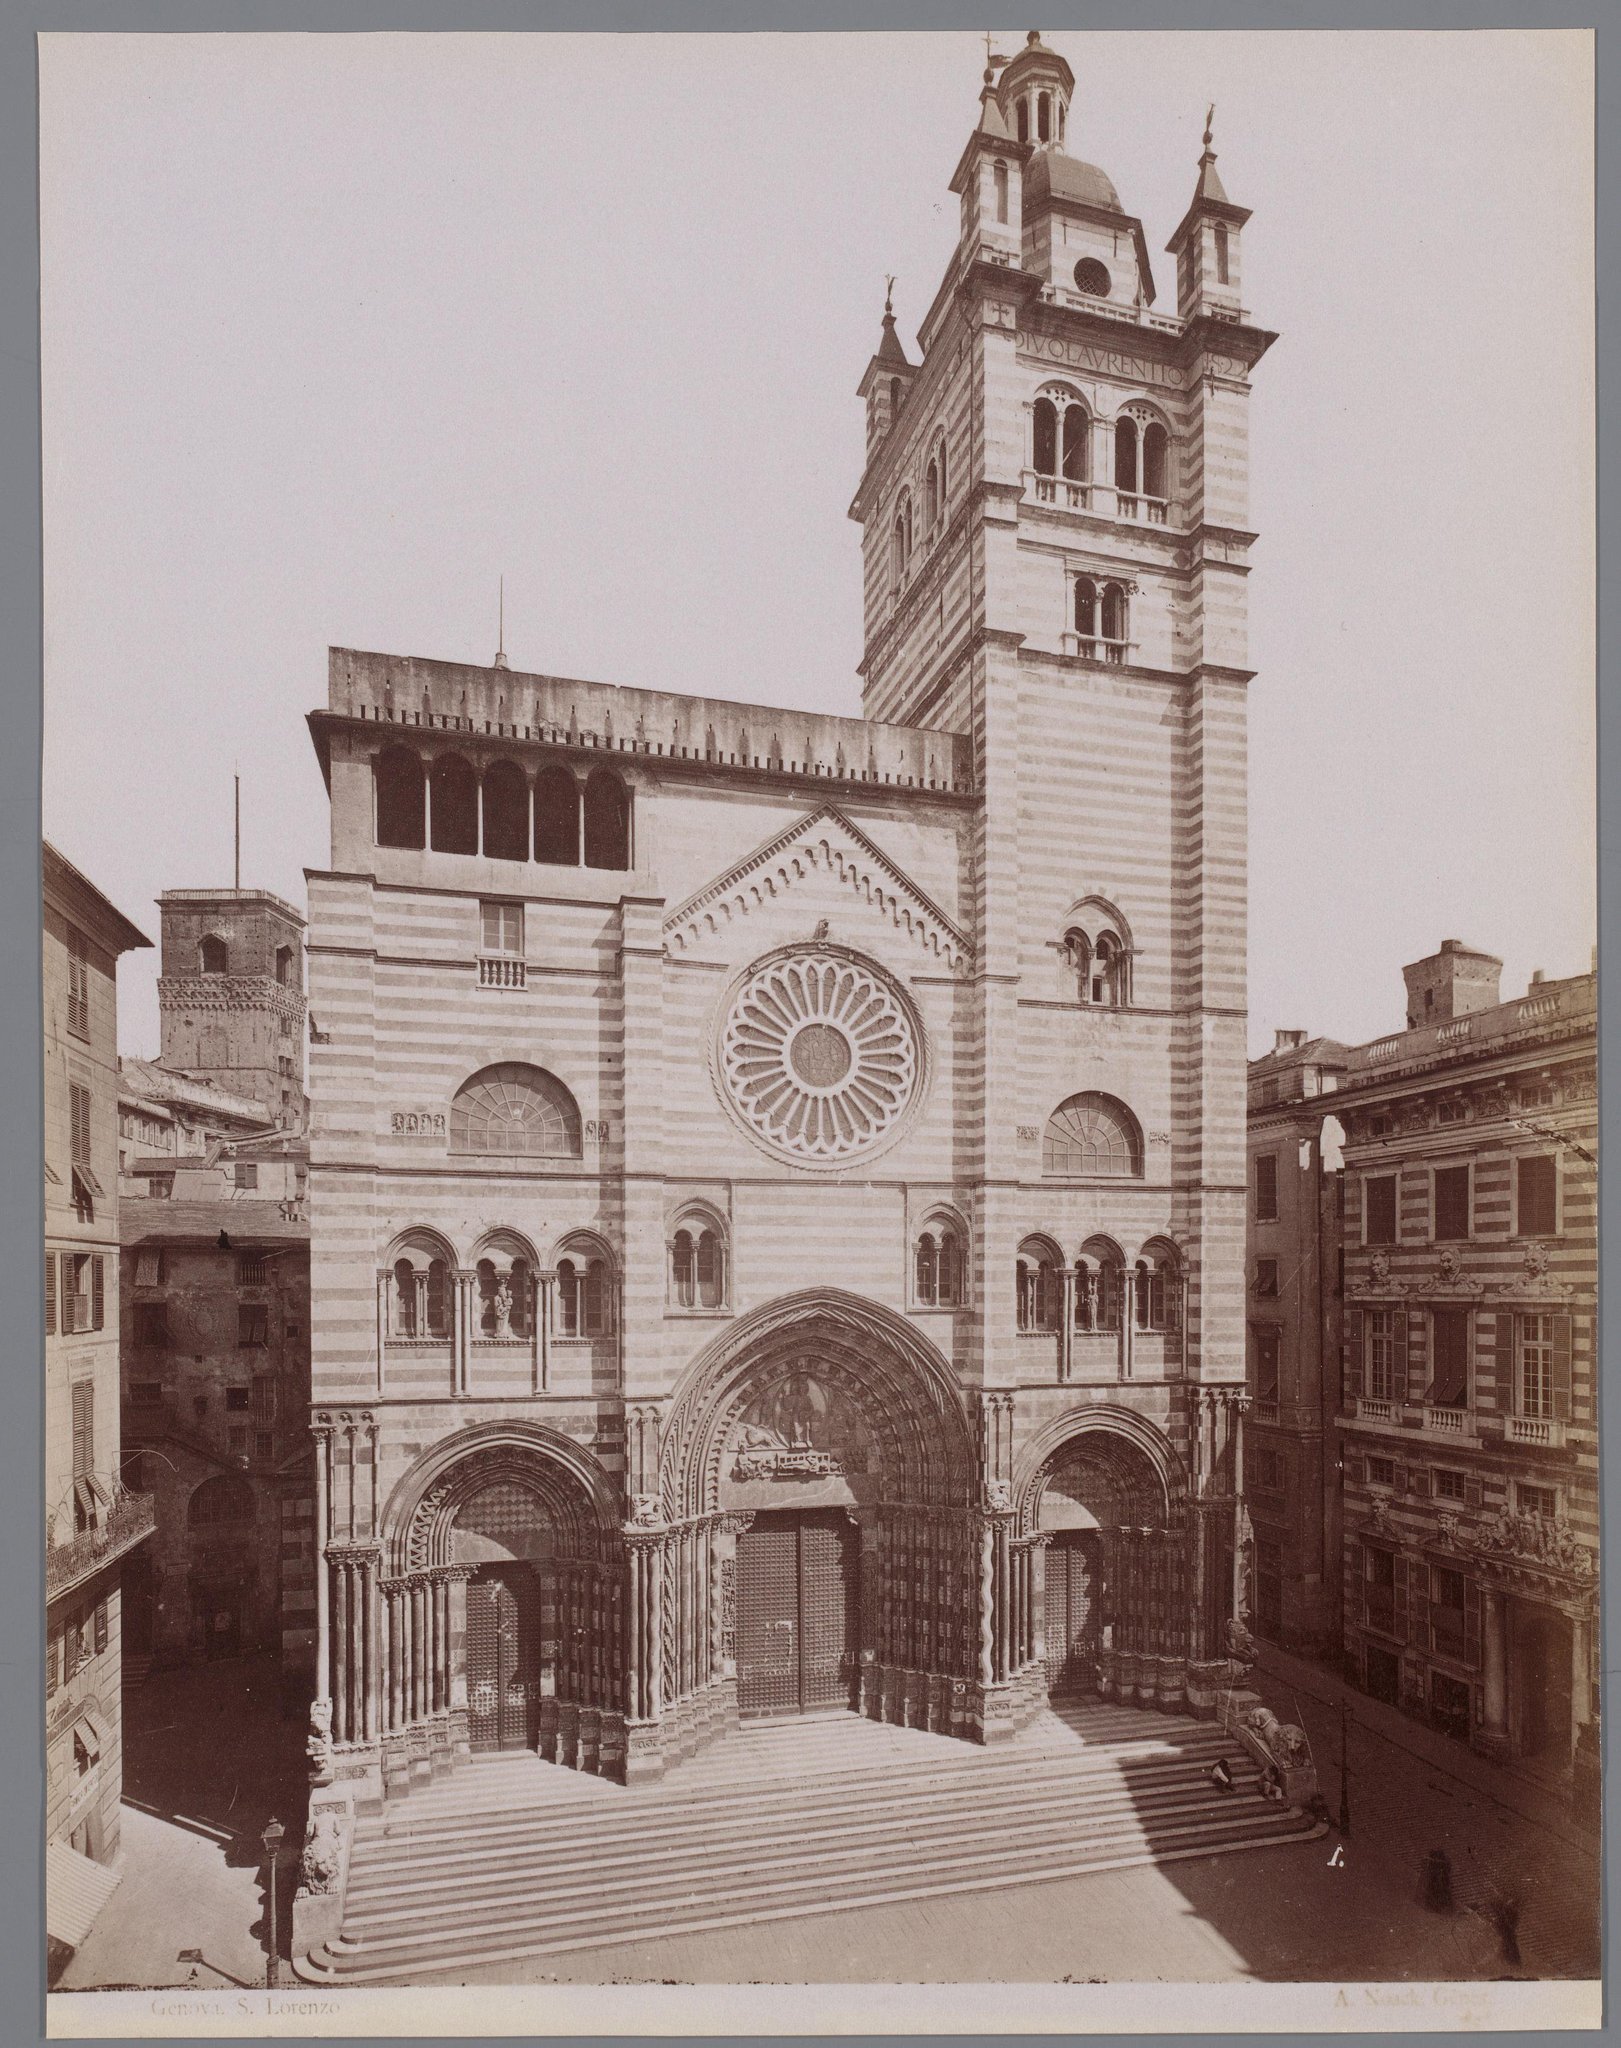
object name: photograph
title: Genova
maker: alfredo noack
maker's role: fotograaf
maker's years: 1833-1895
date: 1858-1893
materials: cardboard, paper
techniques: albumen print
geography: genoa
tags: church (exterior)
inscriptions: number: ‘13’